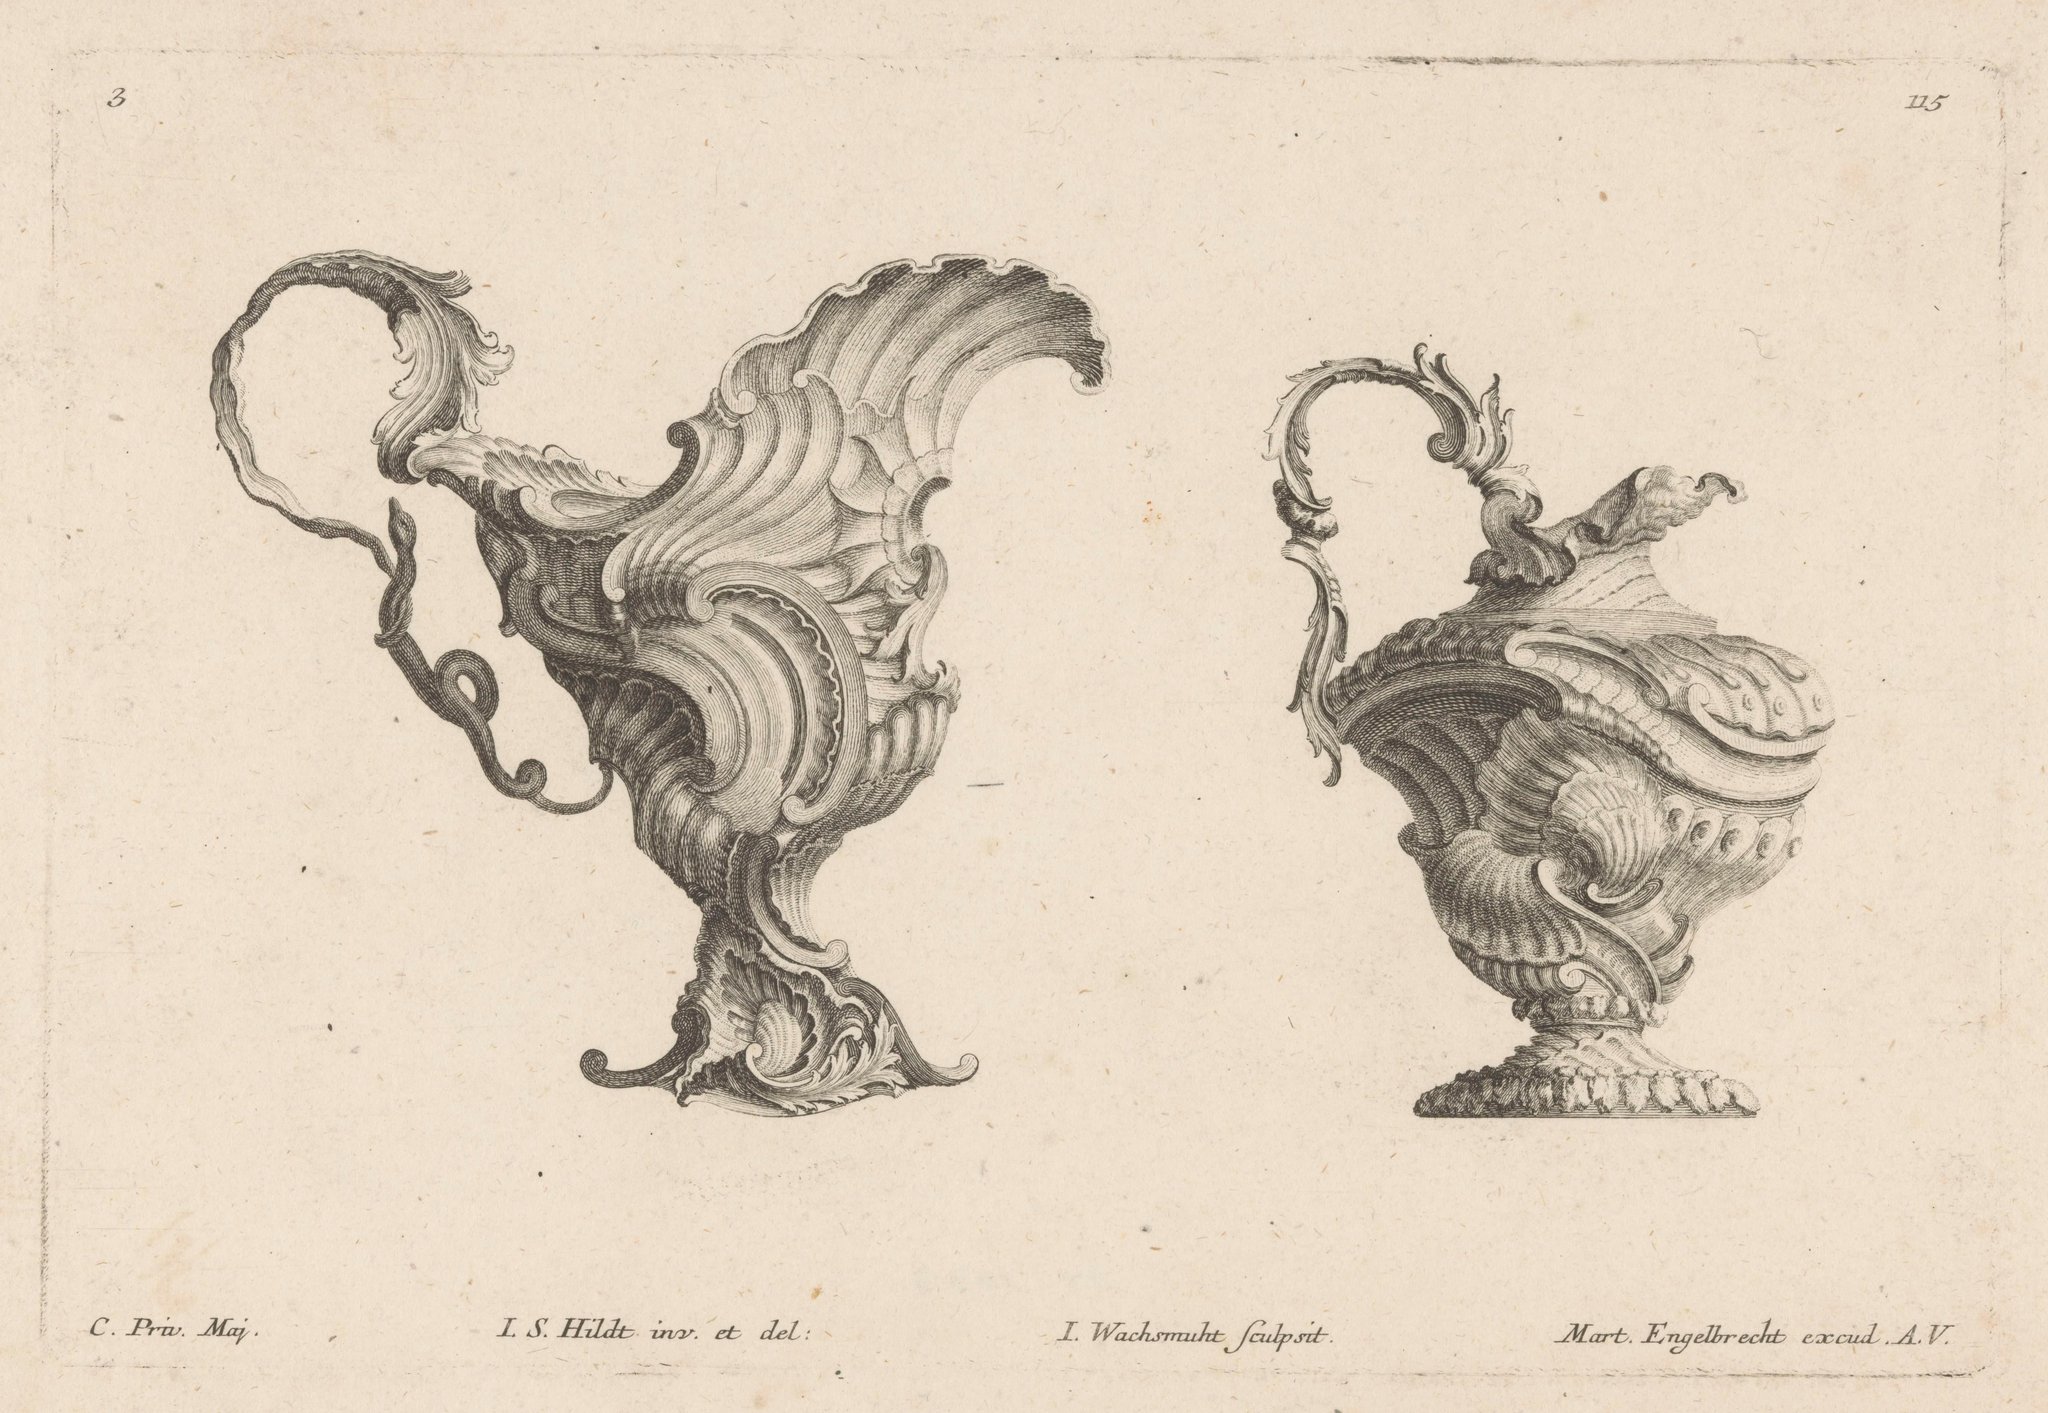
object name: print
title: Sierkannen met slang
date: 1721-1756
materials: paper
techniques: etching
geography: augsburg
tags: snakes, rocaille ornament, vase ~ ornament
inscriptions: collector's mark: Lugt 2228, collector's mark: Lugt 2760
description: Twee rocaille sierkannen. Het oor van de linkerkan is met een slang gedecoreerd. Prentnummer 115.